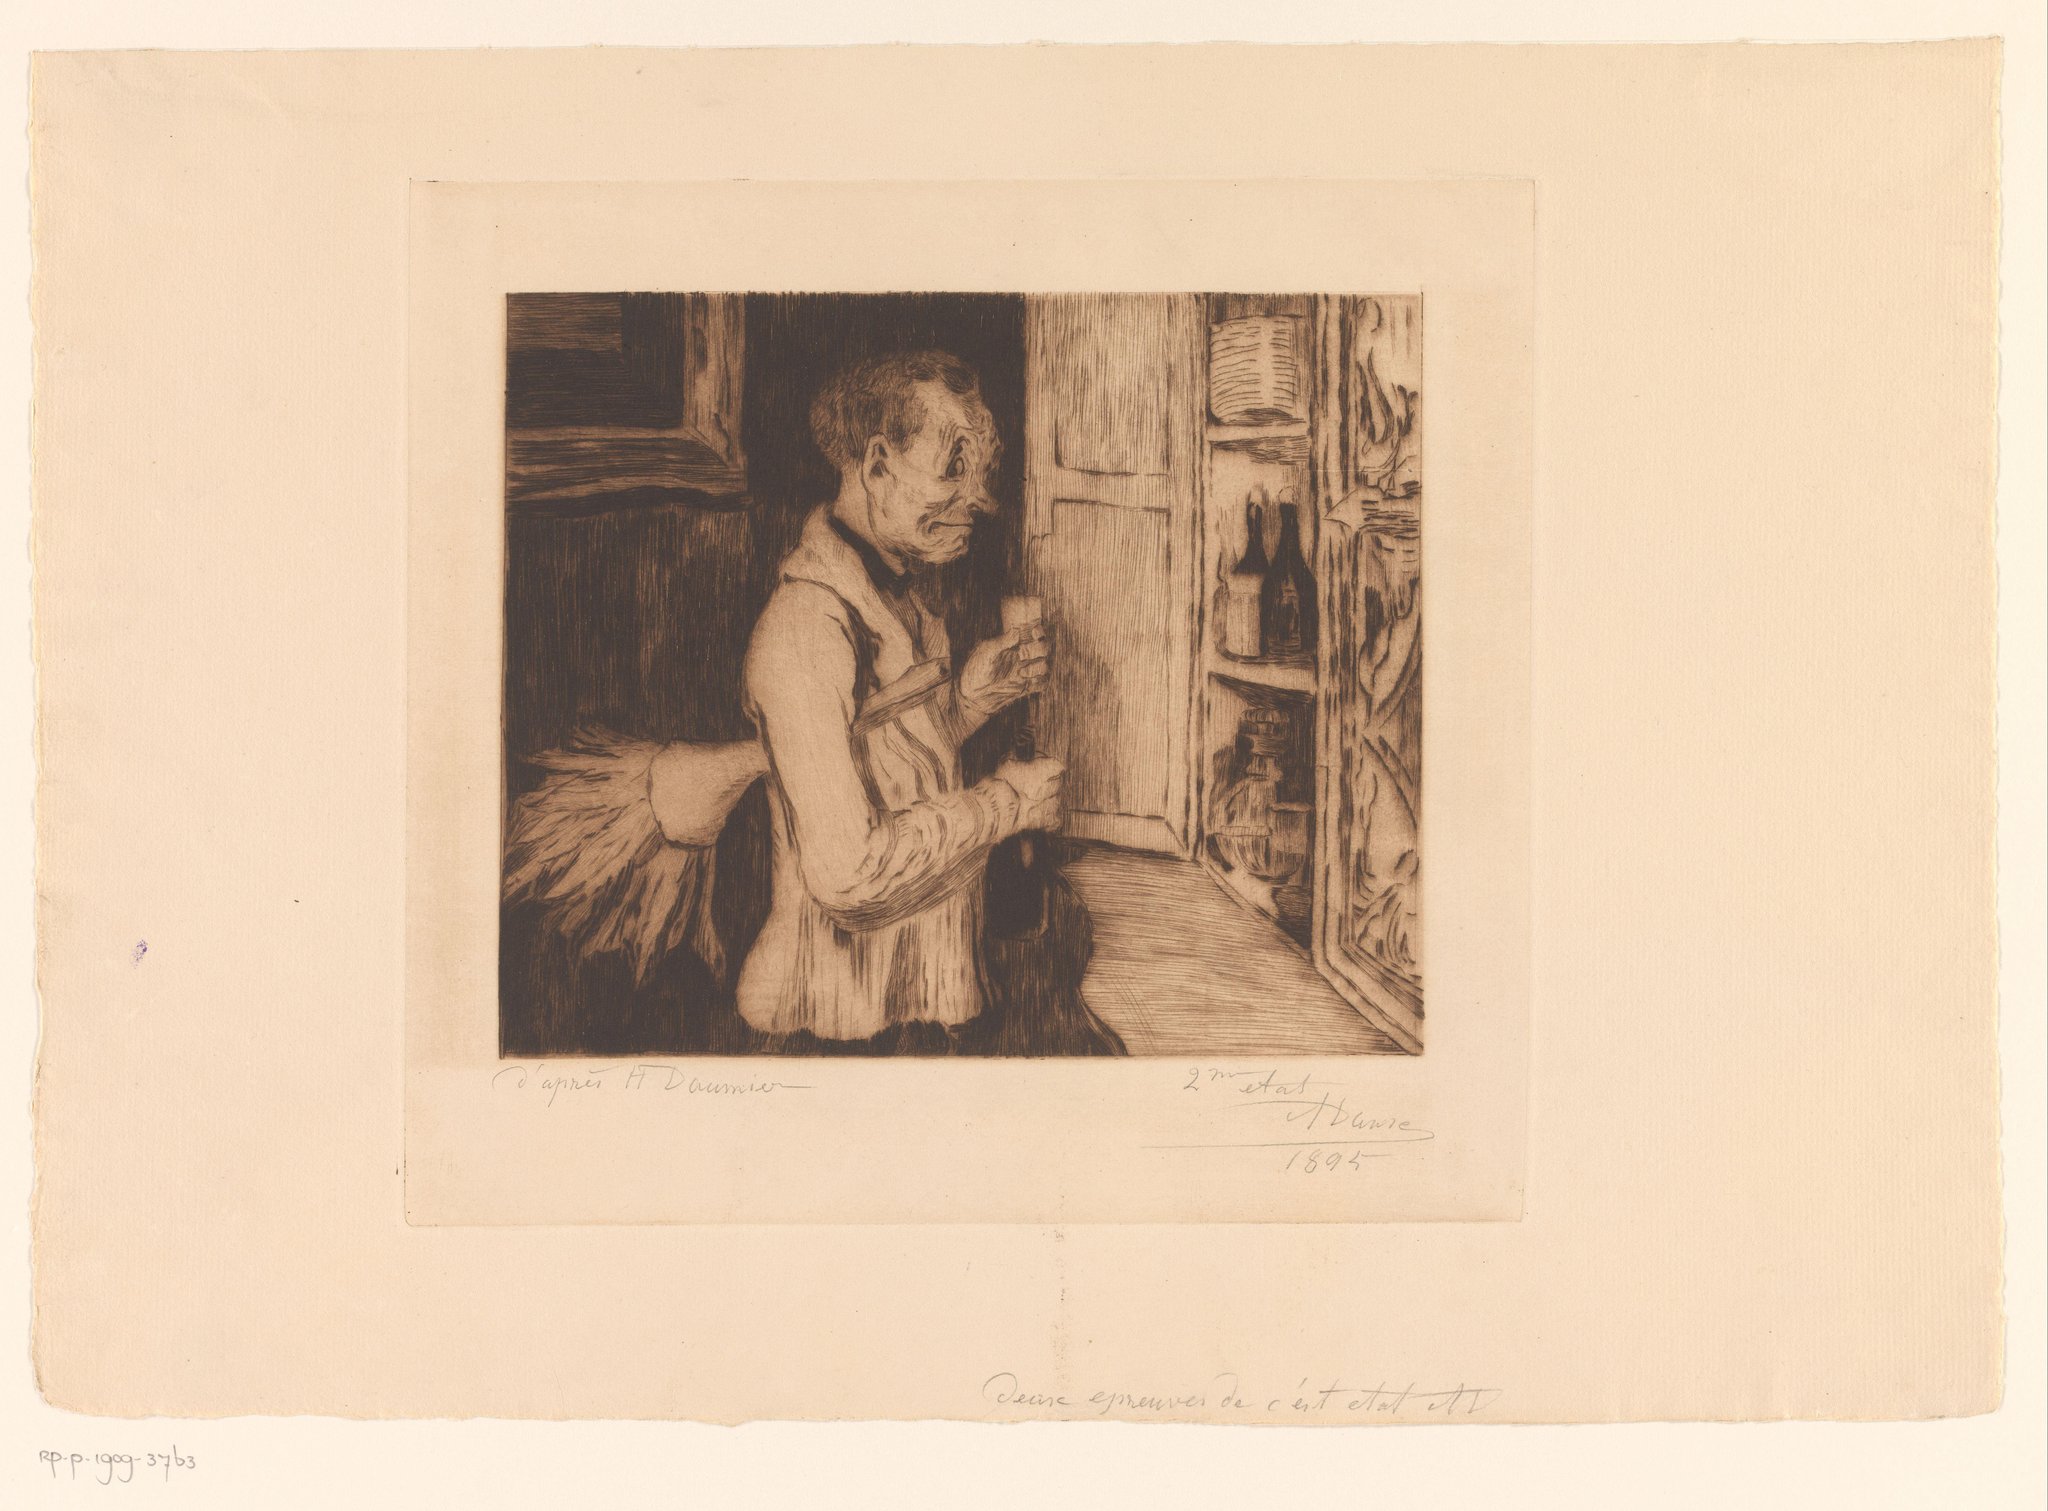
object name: print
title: Butler met een plumeau bij de drankenkast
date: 1895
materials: paper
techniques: drypoint, etching, intaglio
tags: taste, tasting (one of the five senses), butler, alcoholic drinks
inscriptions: annotation: ‘2me etat; deux epreuves de c'est etat’, collector's mark: Lugt 2228